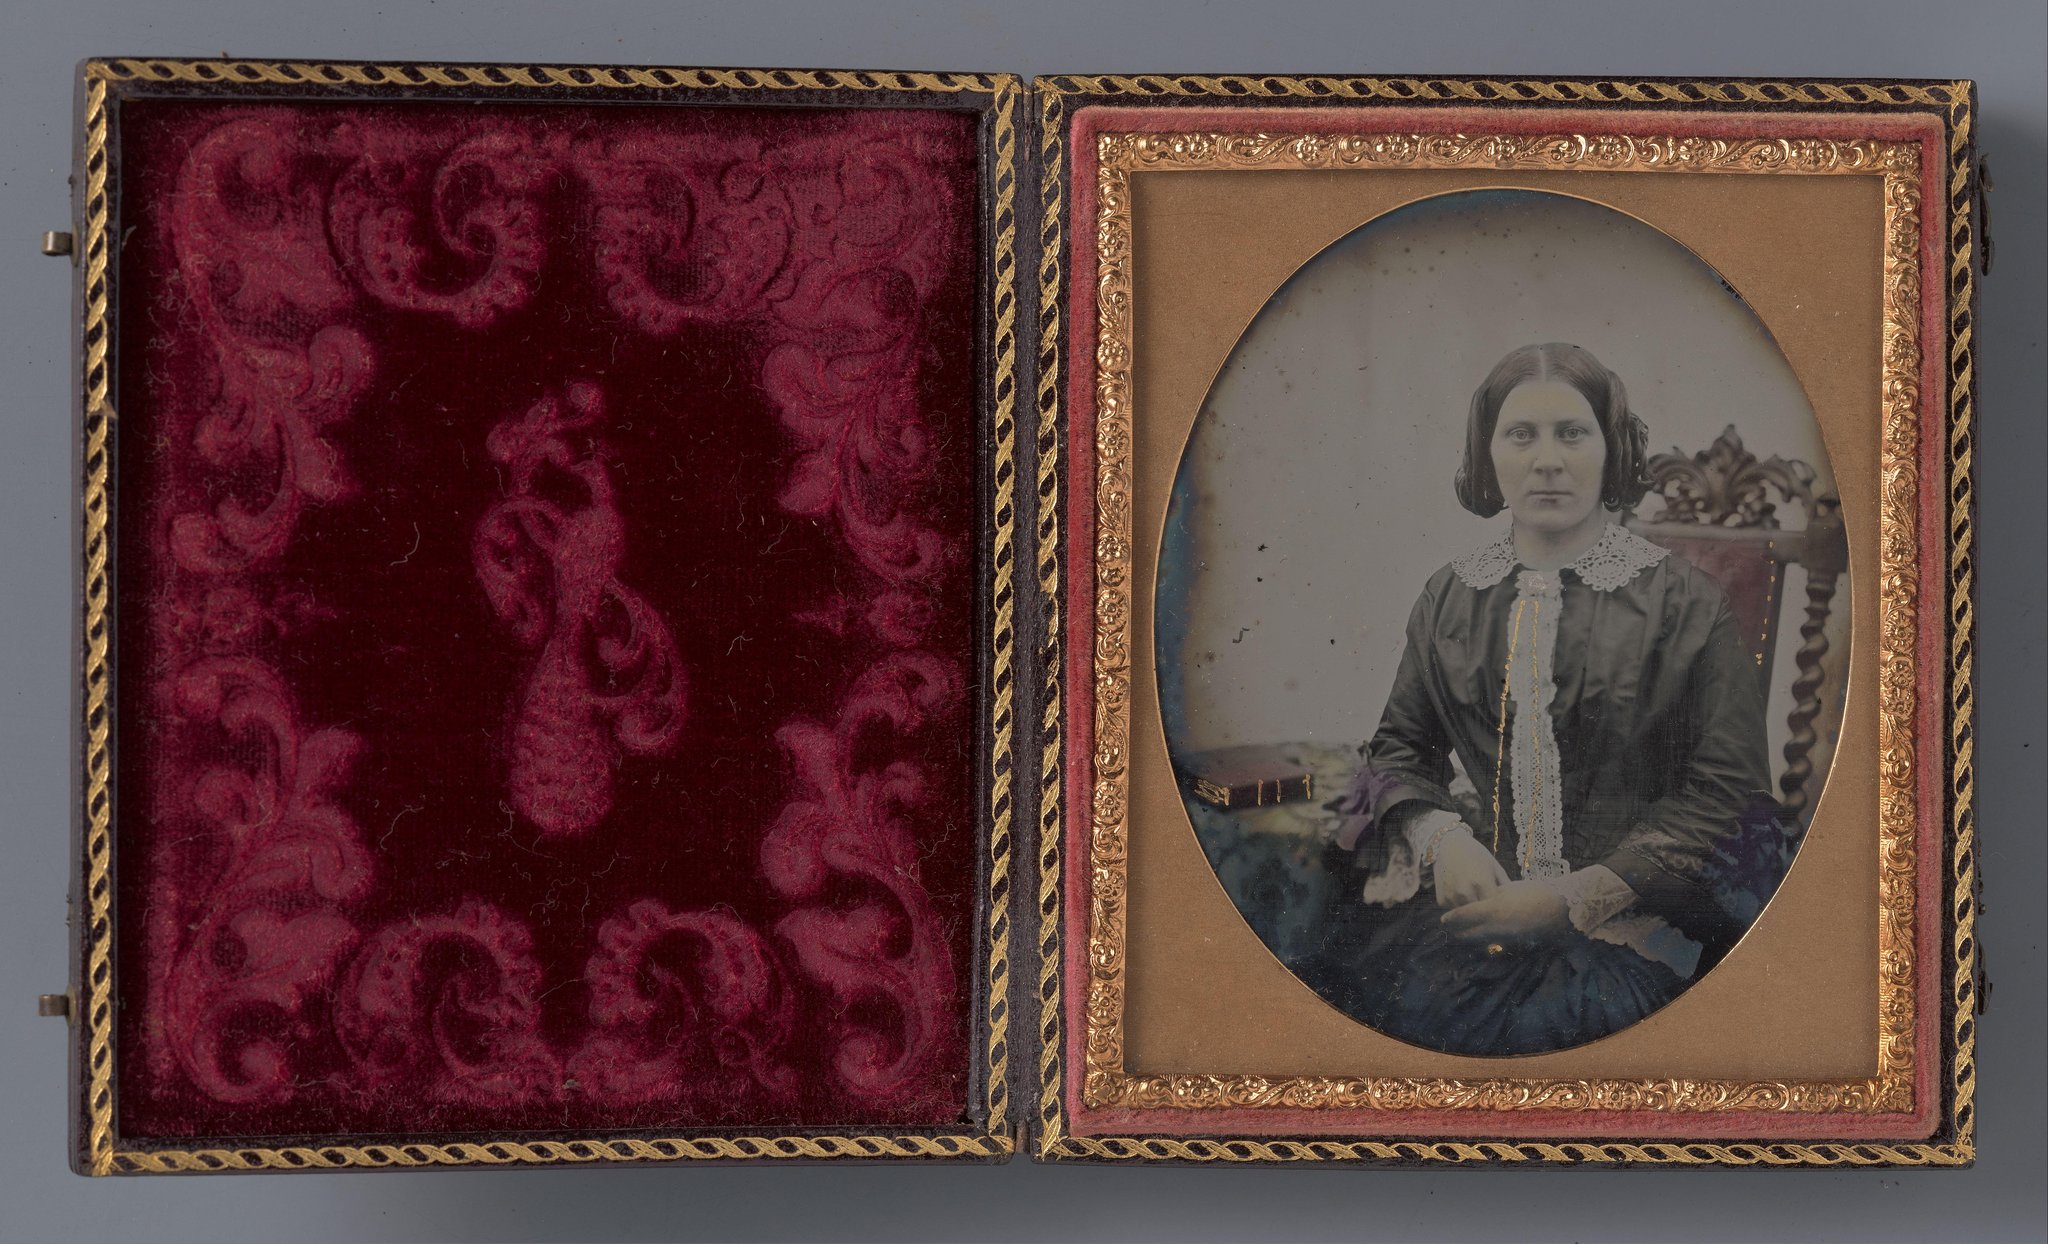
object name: photograph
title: Portret van een onbekende jonge vrouw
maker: Anonymous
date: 1858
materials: glass, leather, metal, velvet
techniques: ambrotype, hand coloring